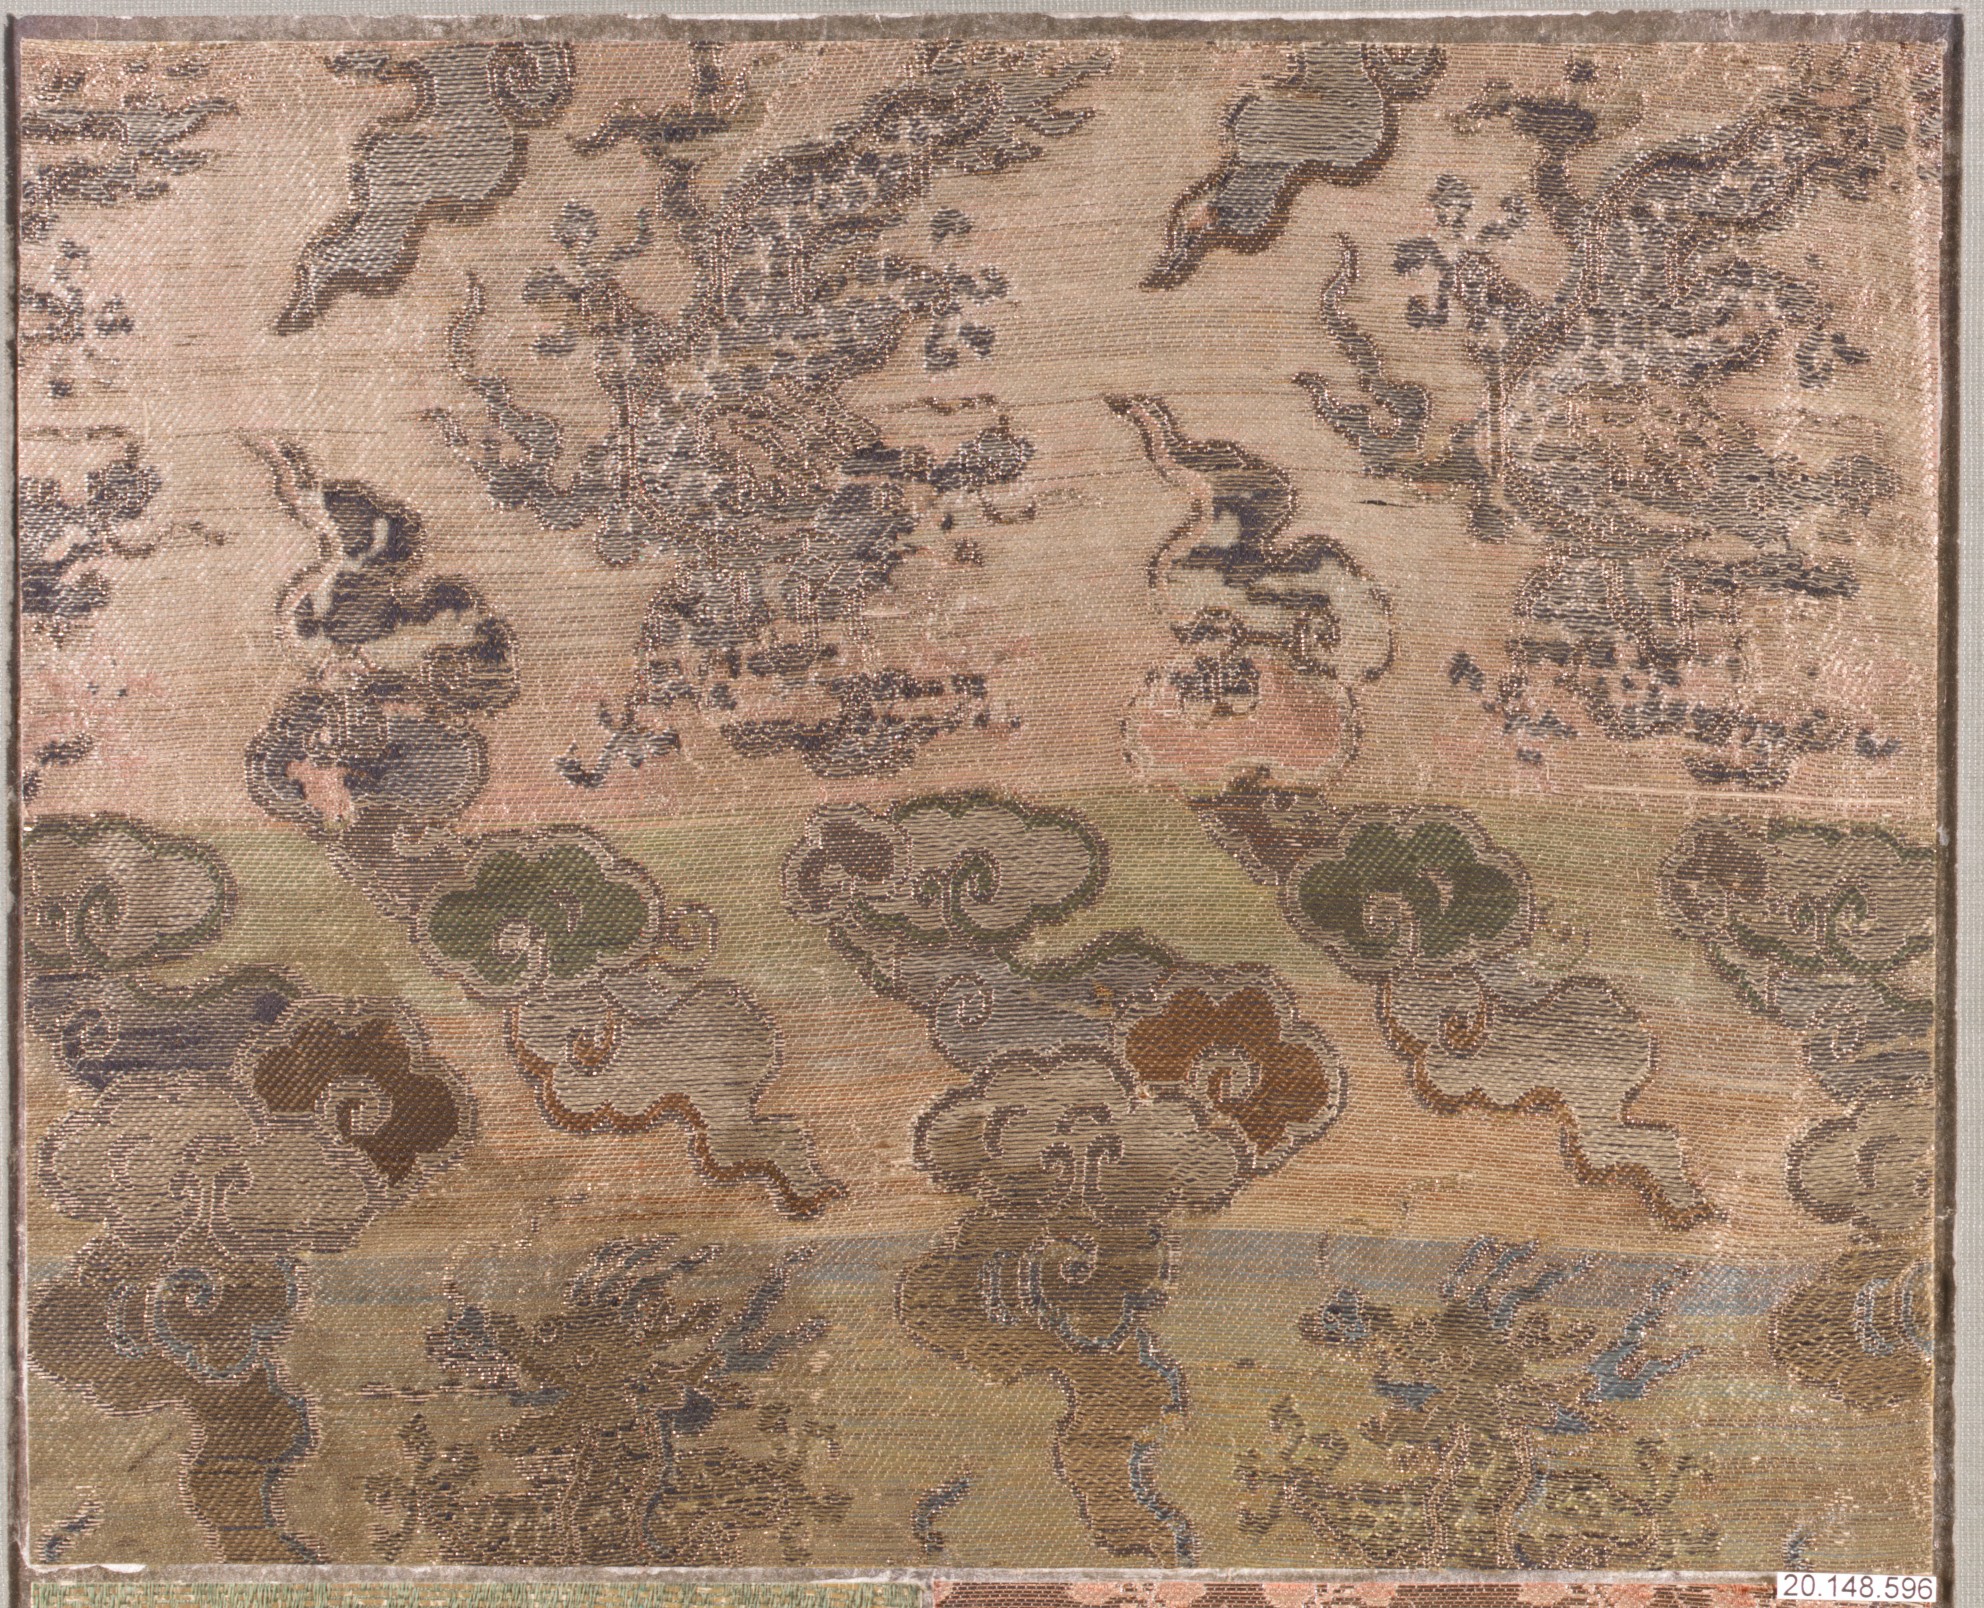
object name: piece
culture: japanese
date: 1601-1700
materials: silk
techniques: compound weave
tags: dragons